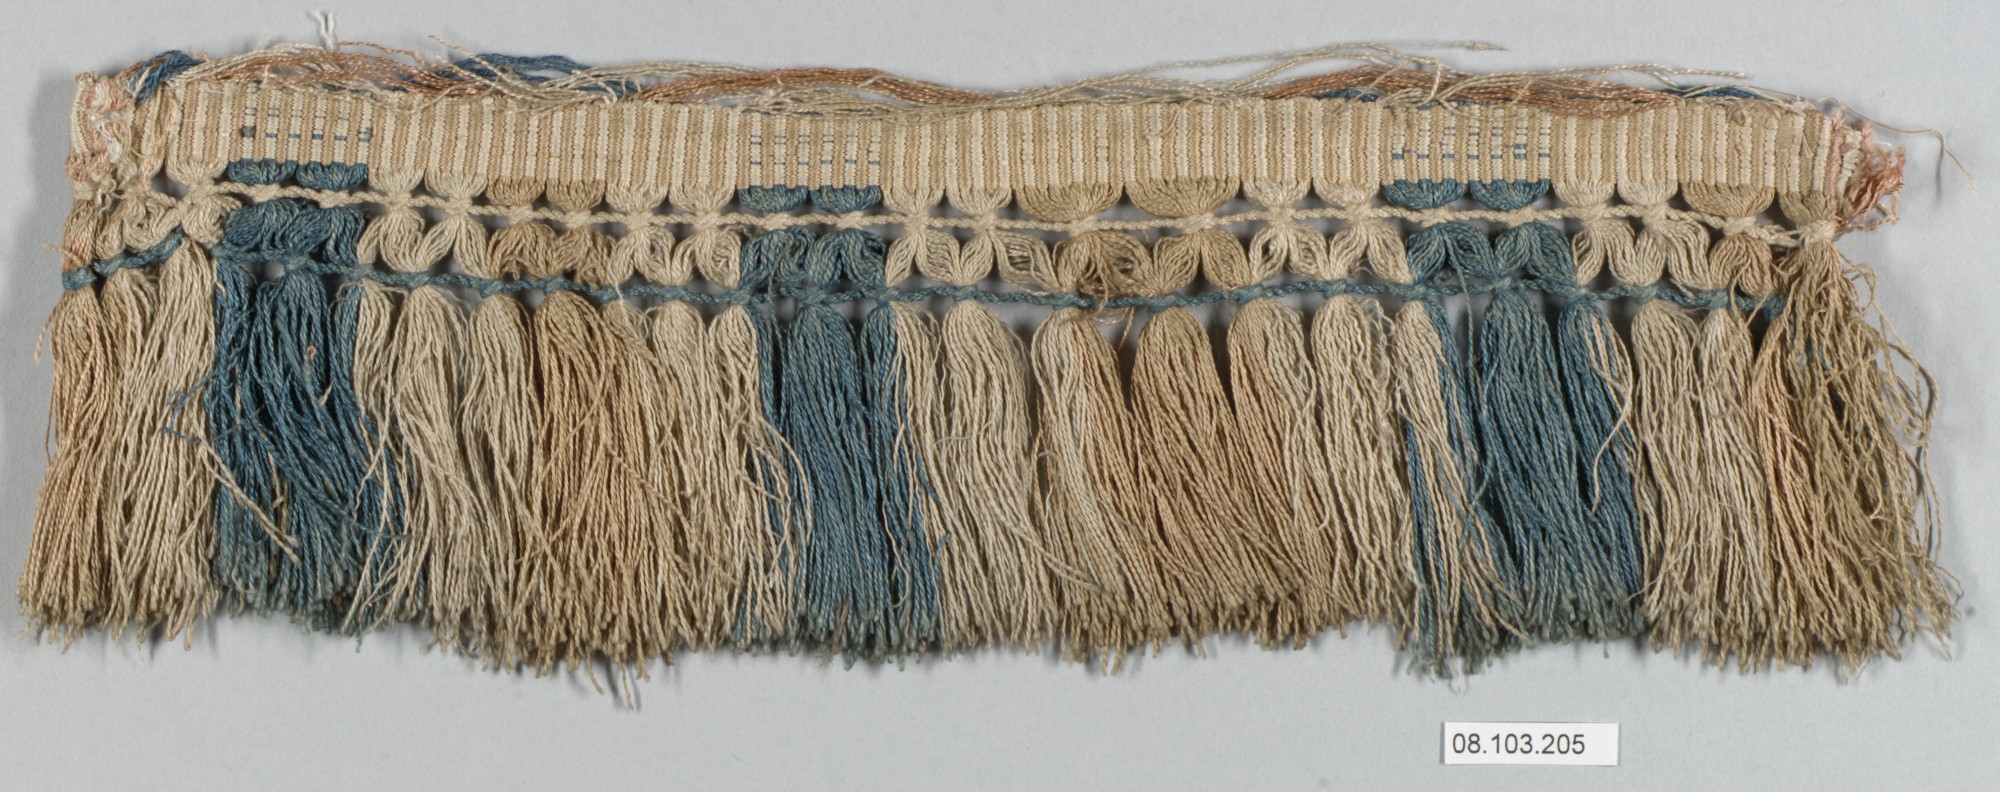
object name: fringe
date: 1801-1900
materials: silk